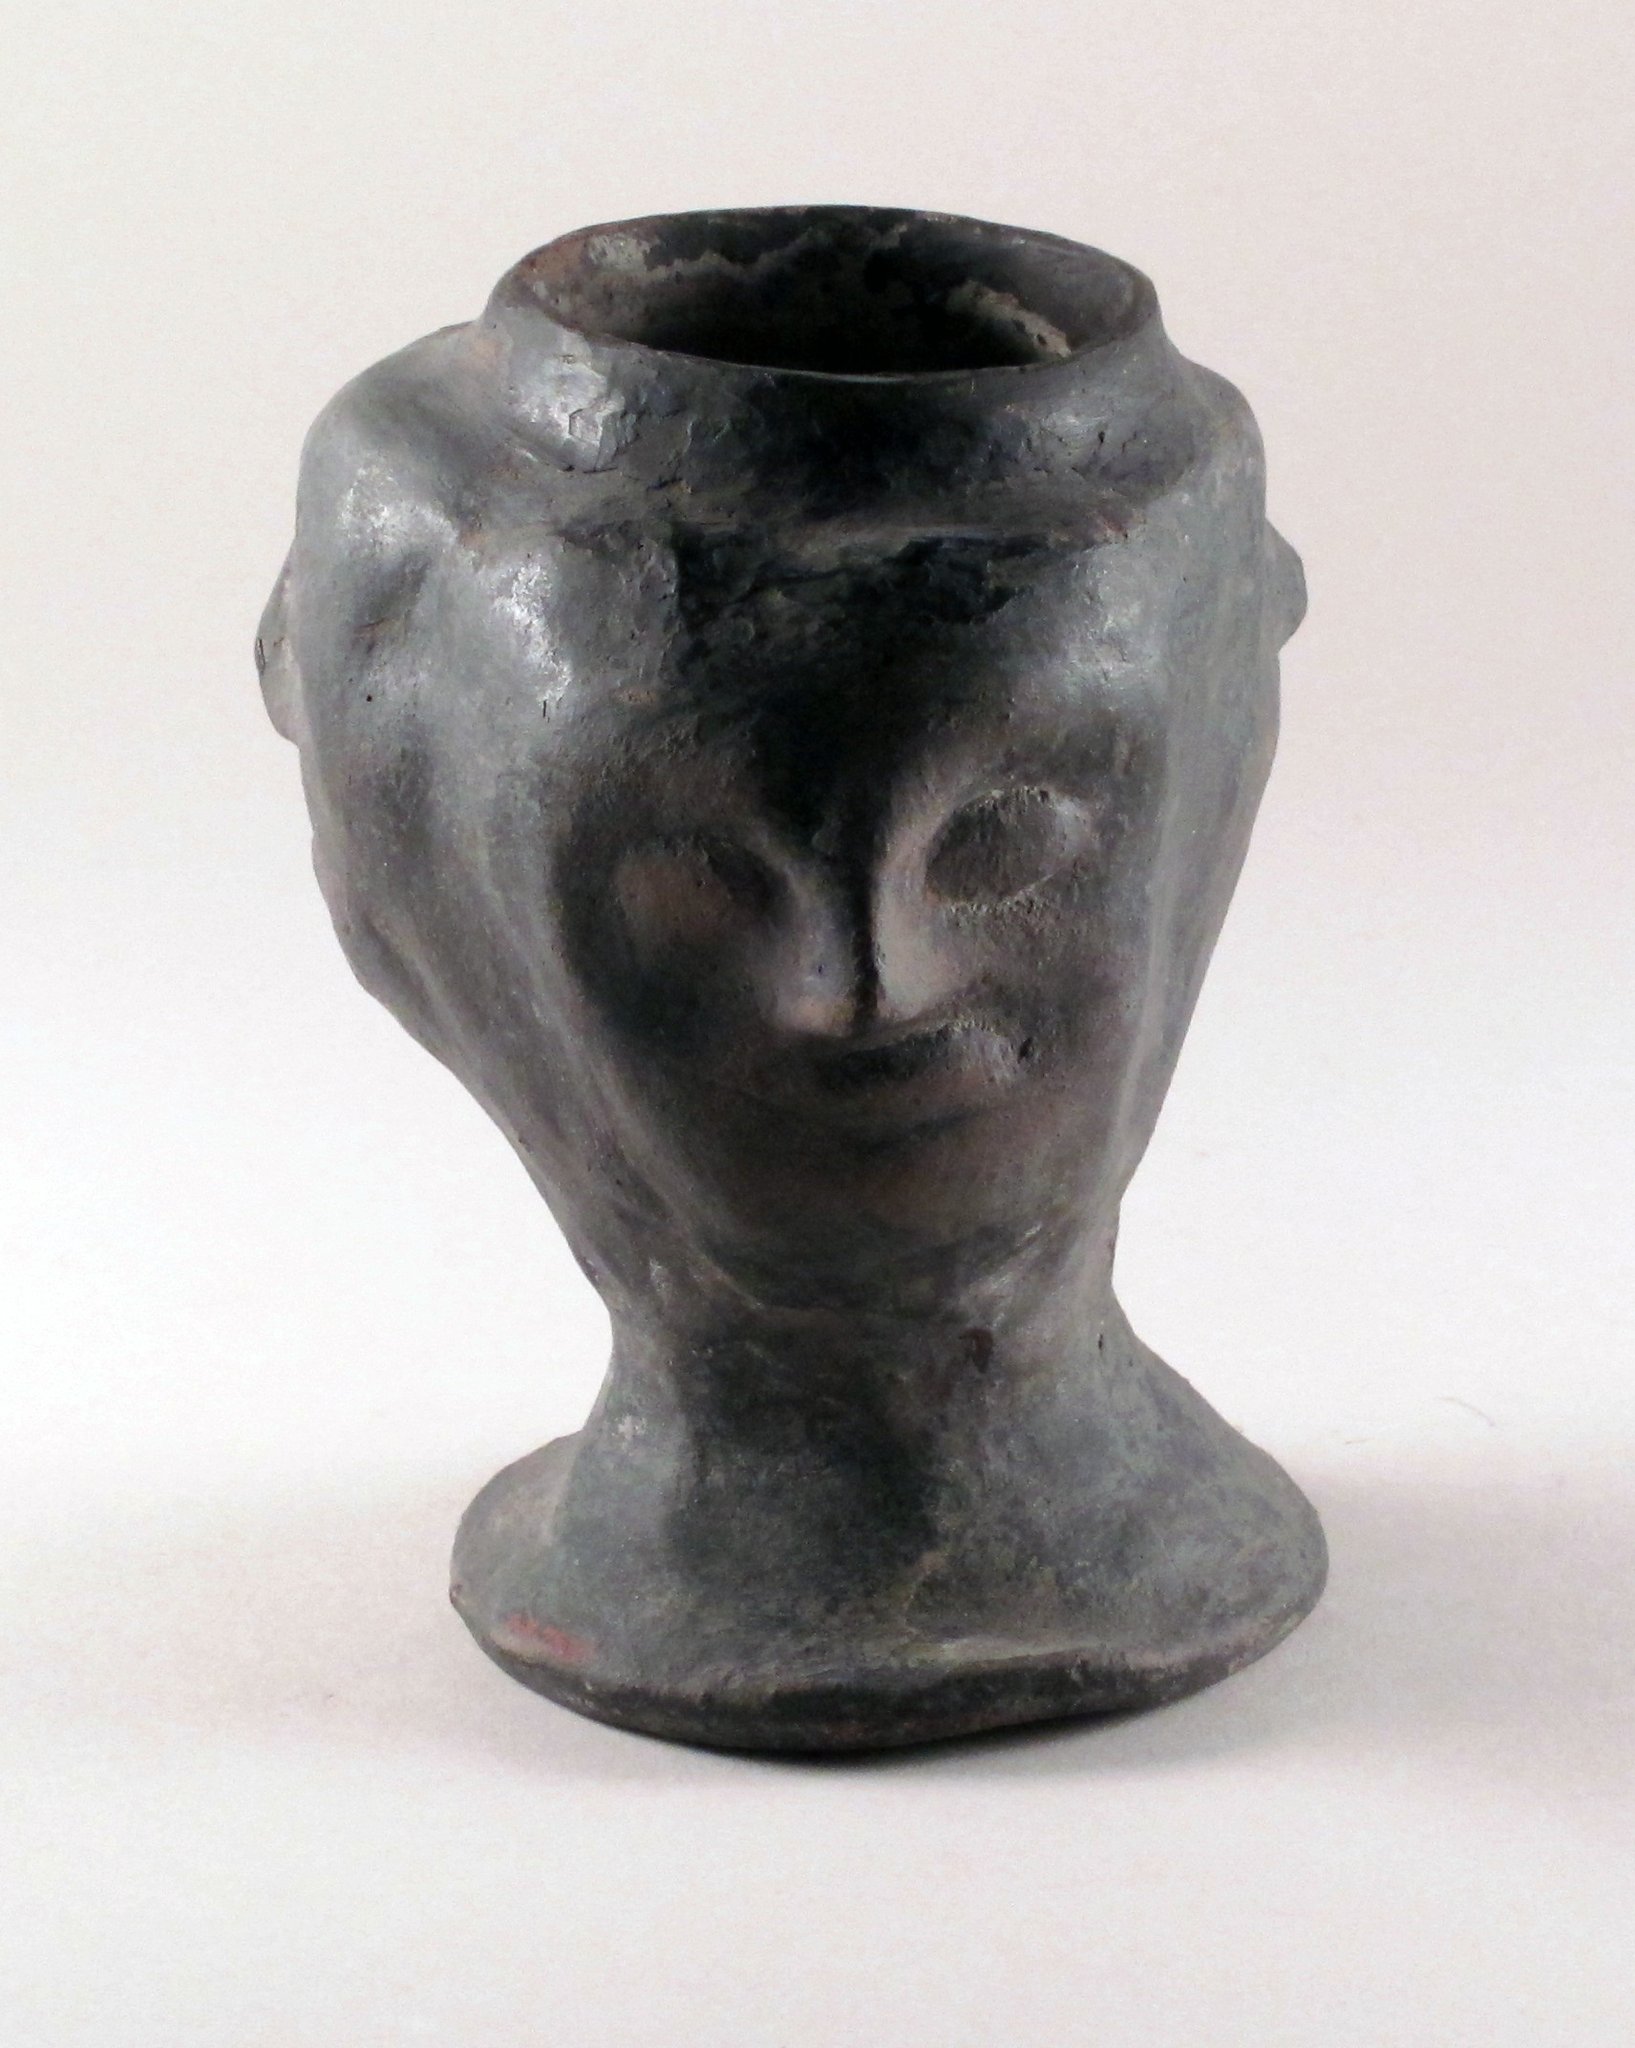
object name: jug with lid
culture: etruscan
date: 634-501 BCE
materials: terracotta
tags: heads